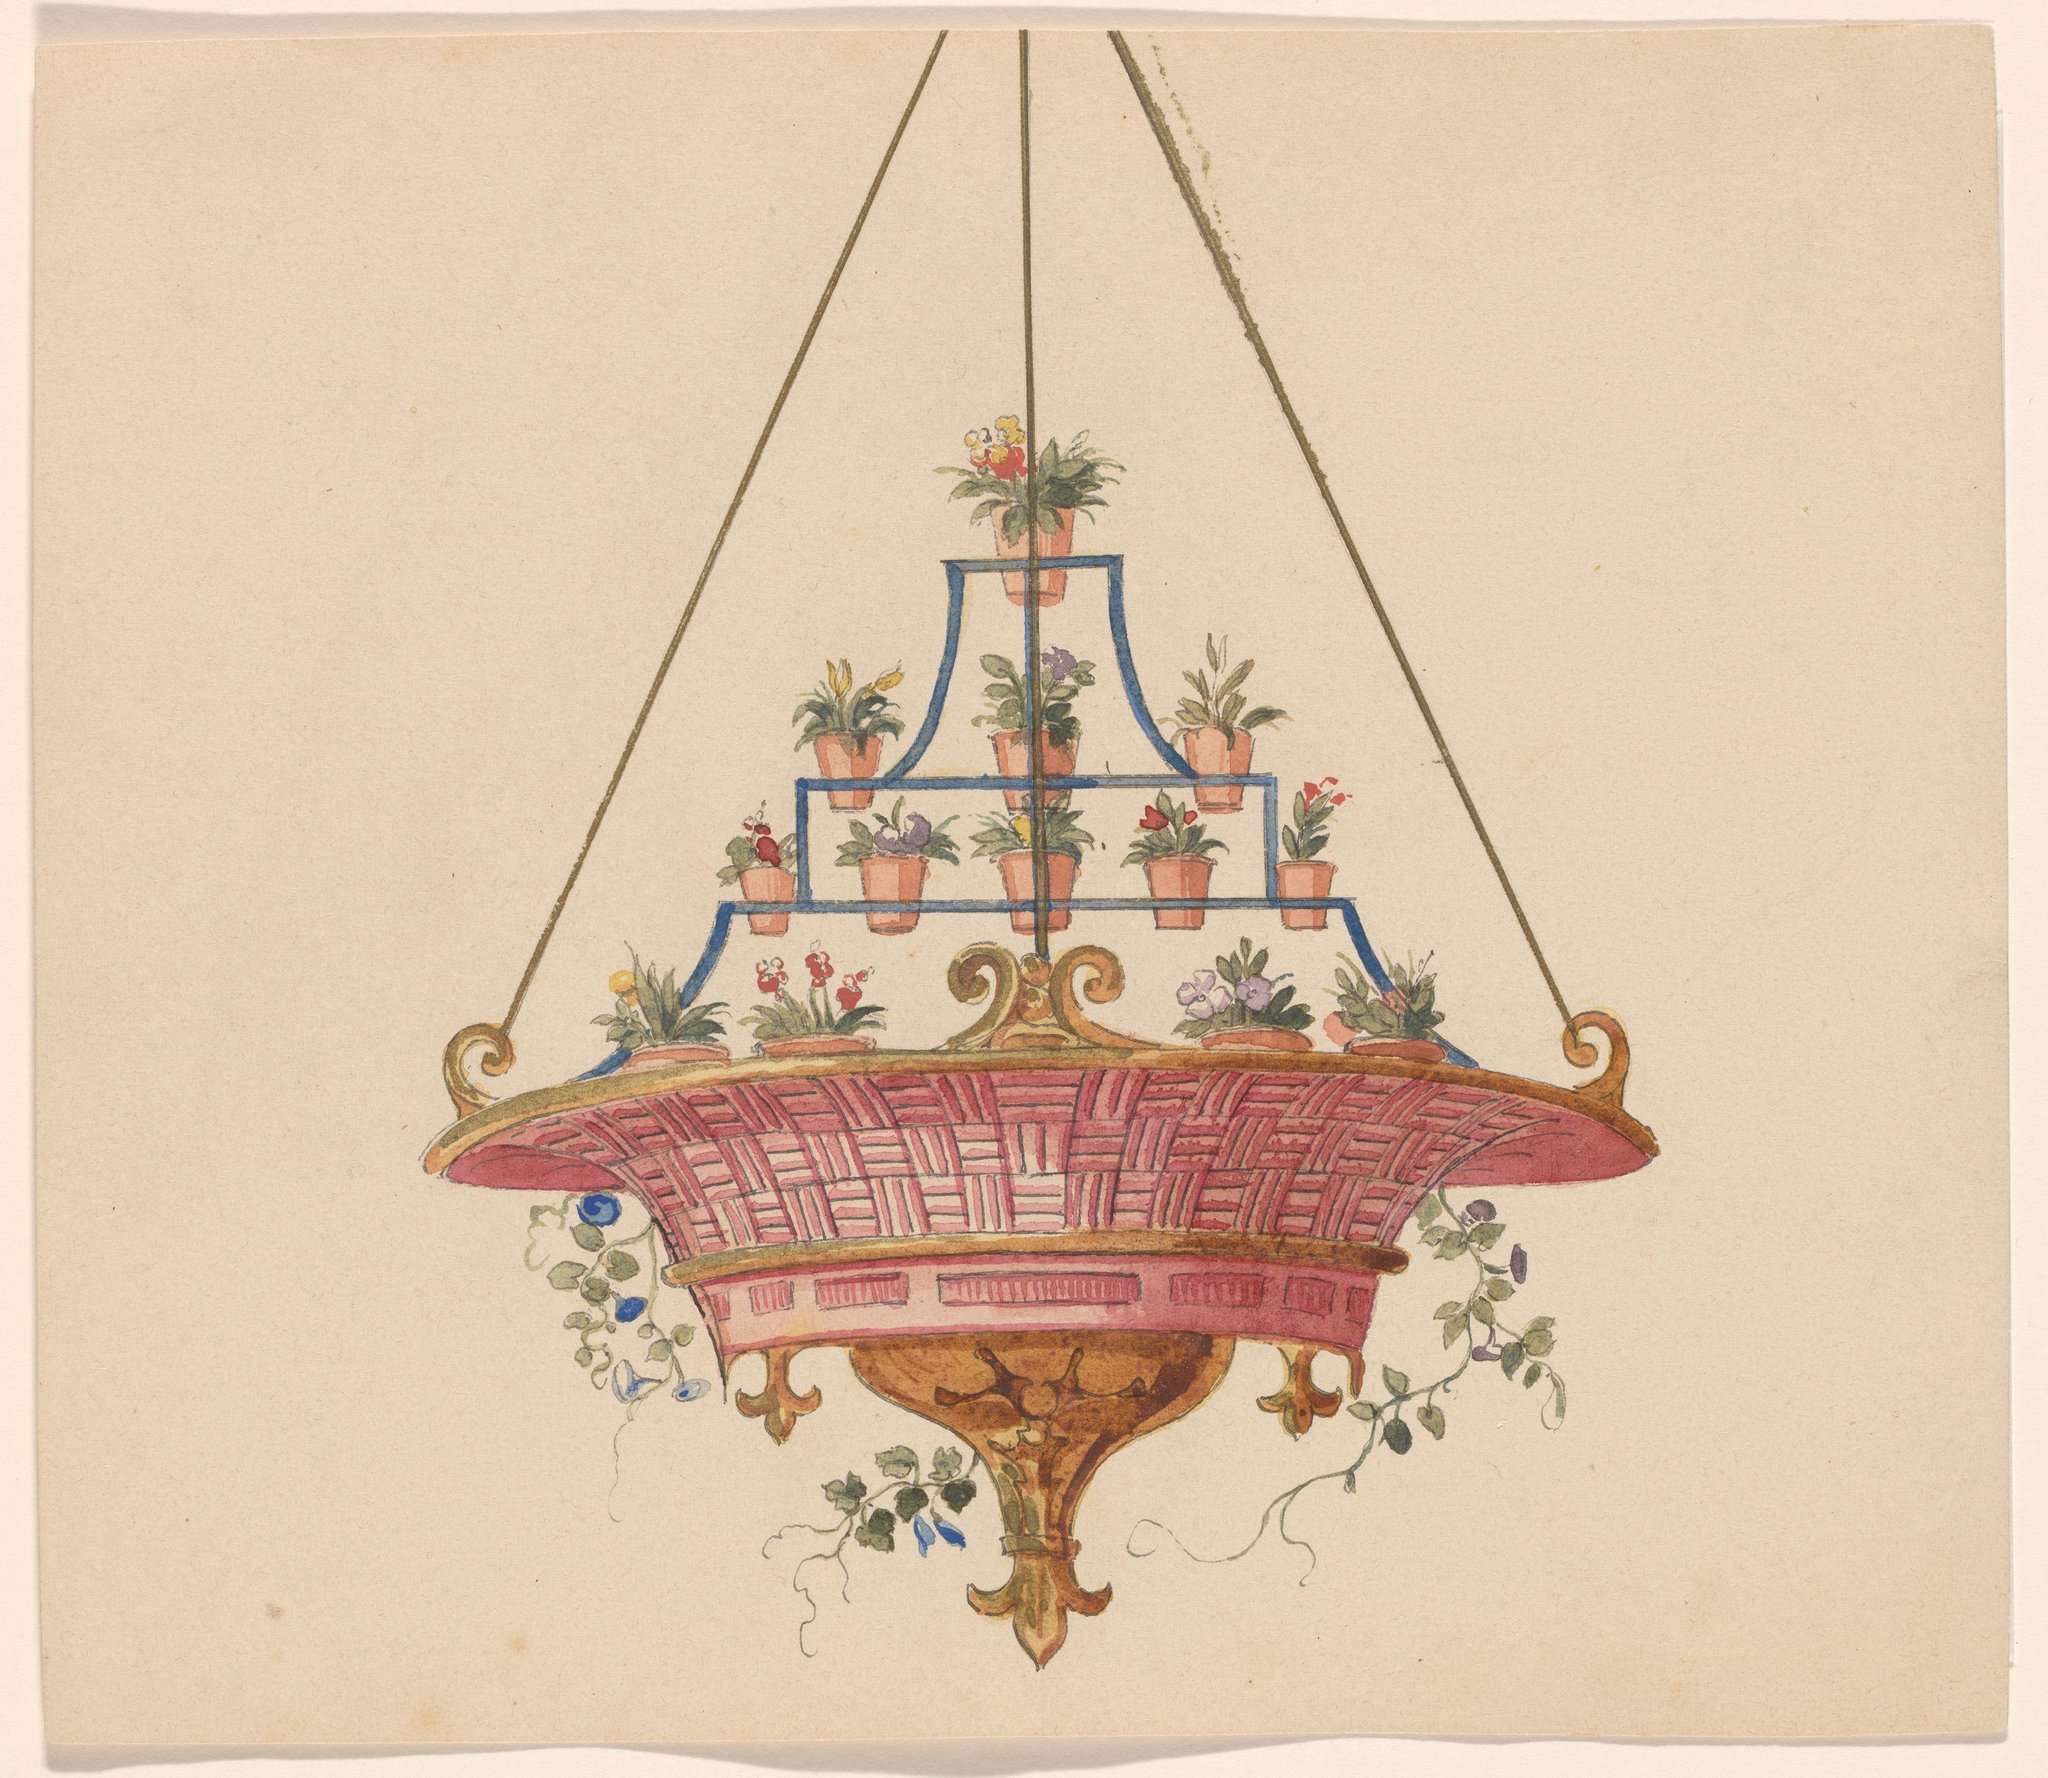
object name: design drawing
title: Jardinière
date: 1830-1850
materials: paint, ink, paper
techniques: aquarelle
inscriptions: inscription: ‘HEINRICH JENNY’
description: Hangende jardinière in de vorm van een roze mand met een opstand.